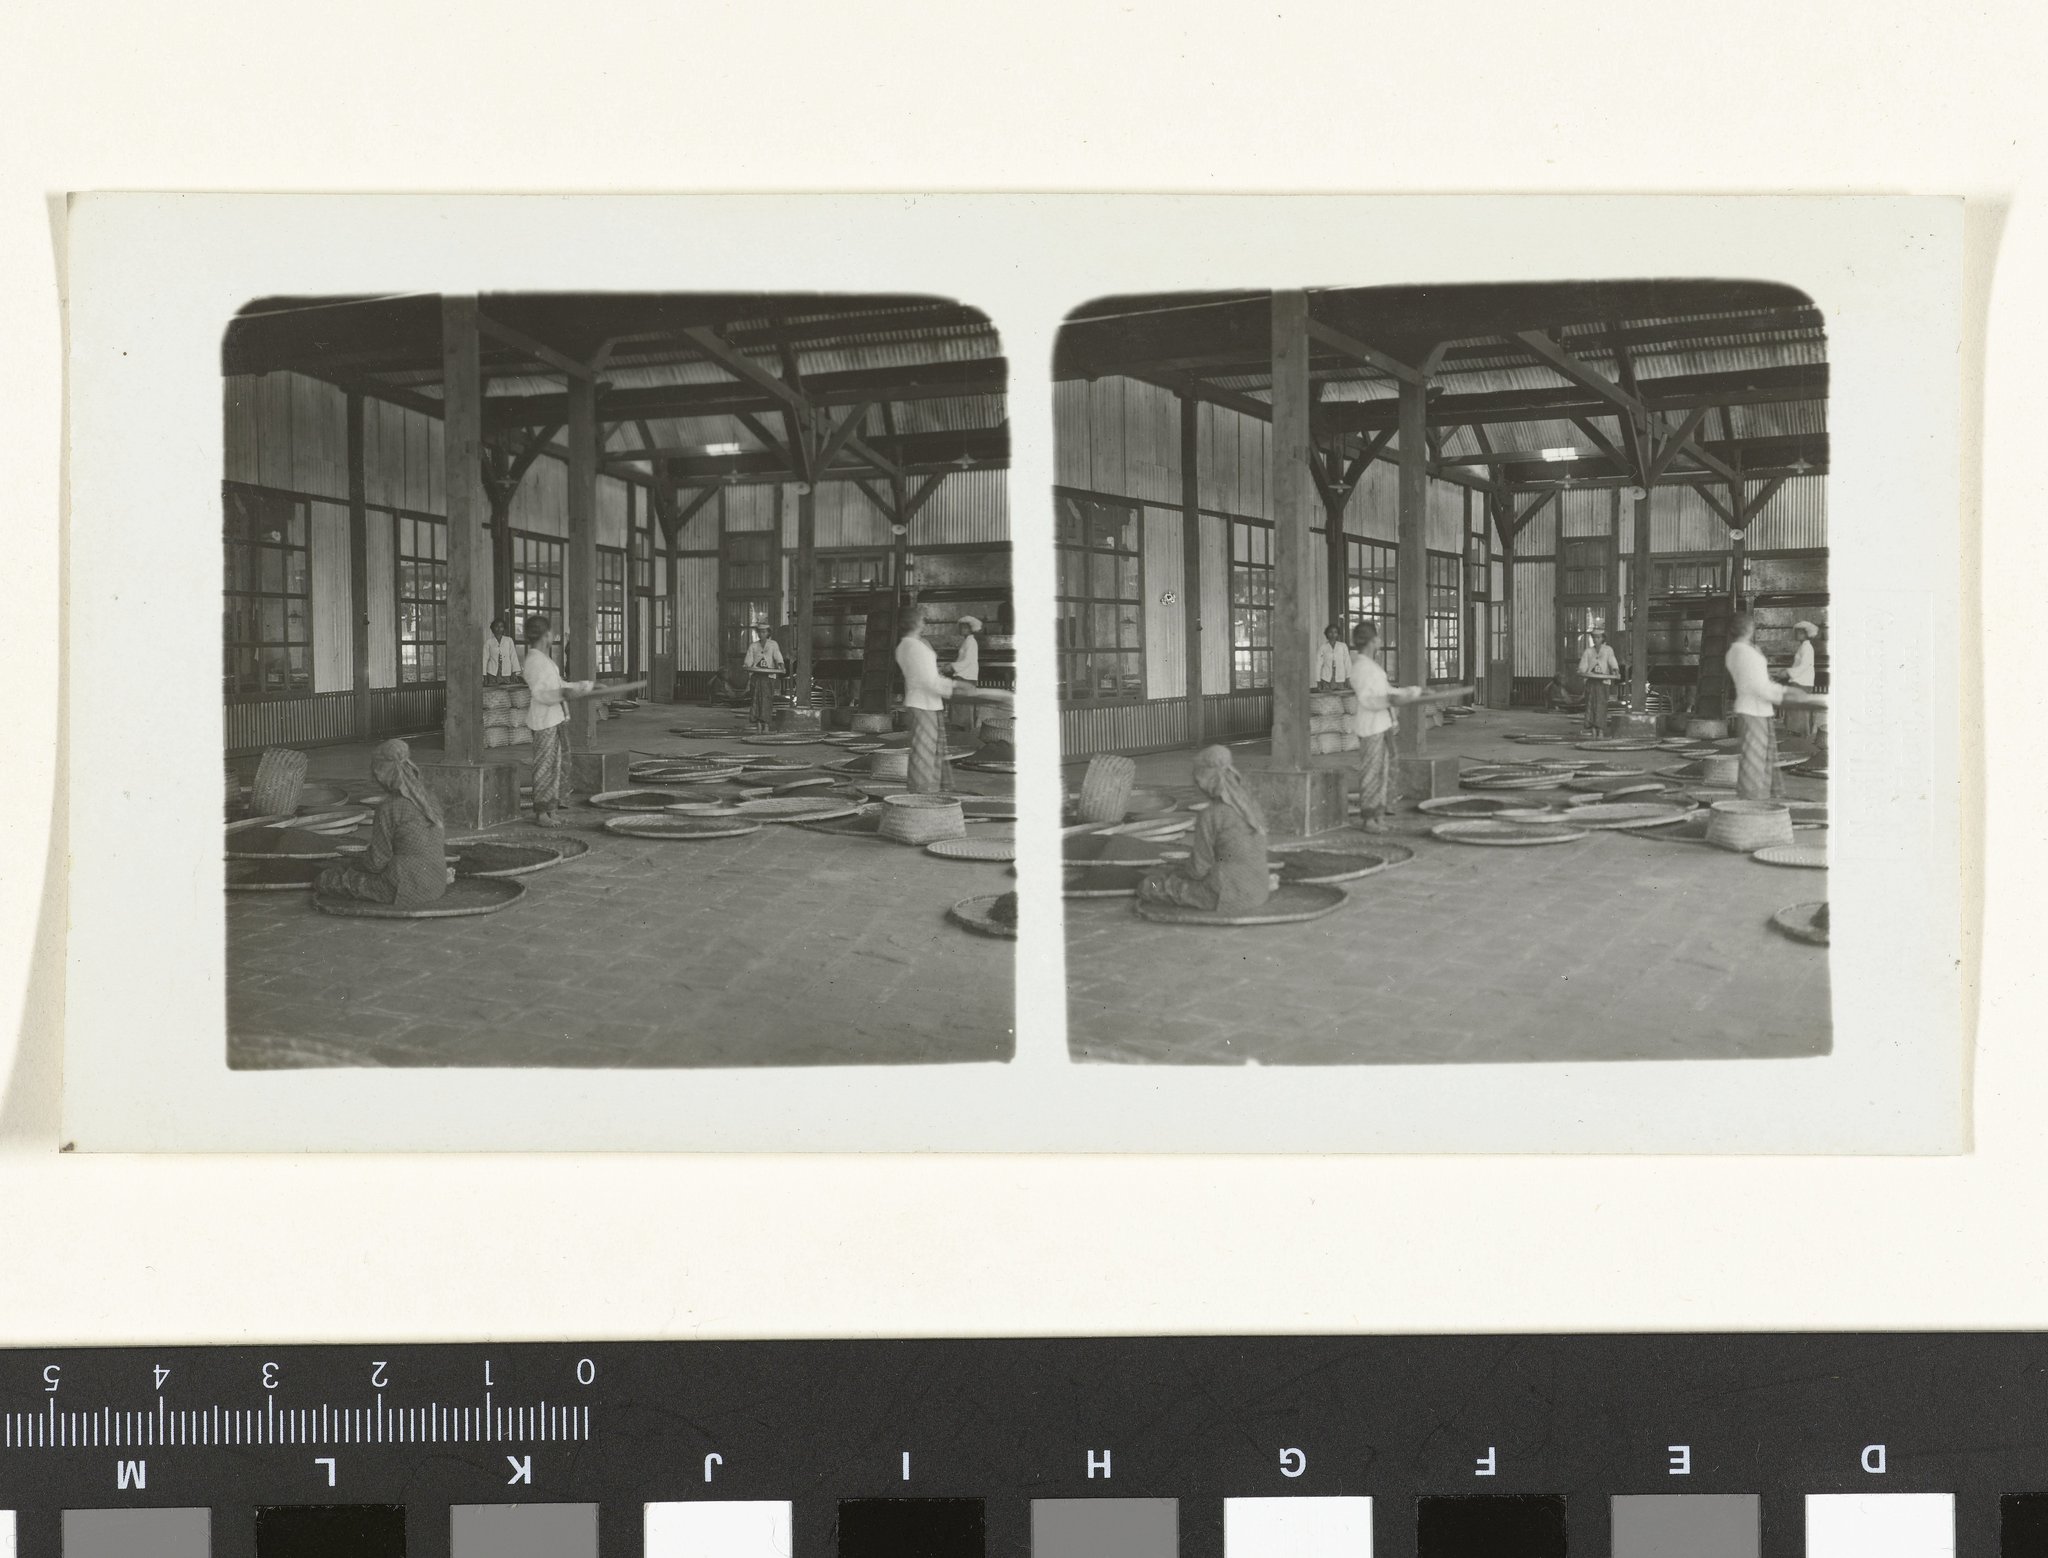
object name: photograph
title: Thee sorteren in een fabriekshal.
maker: neville keasberry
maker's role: fotograaf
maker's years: 1866-1944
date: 1900-1935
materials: cardboard, paper, photographic support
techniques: albumen print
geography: malang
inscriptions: signature: ‘Neville Keasberry, Malang (Java)’